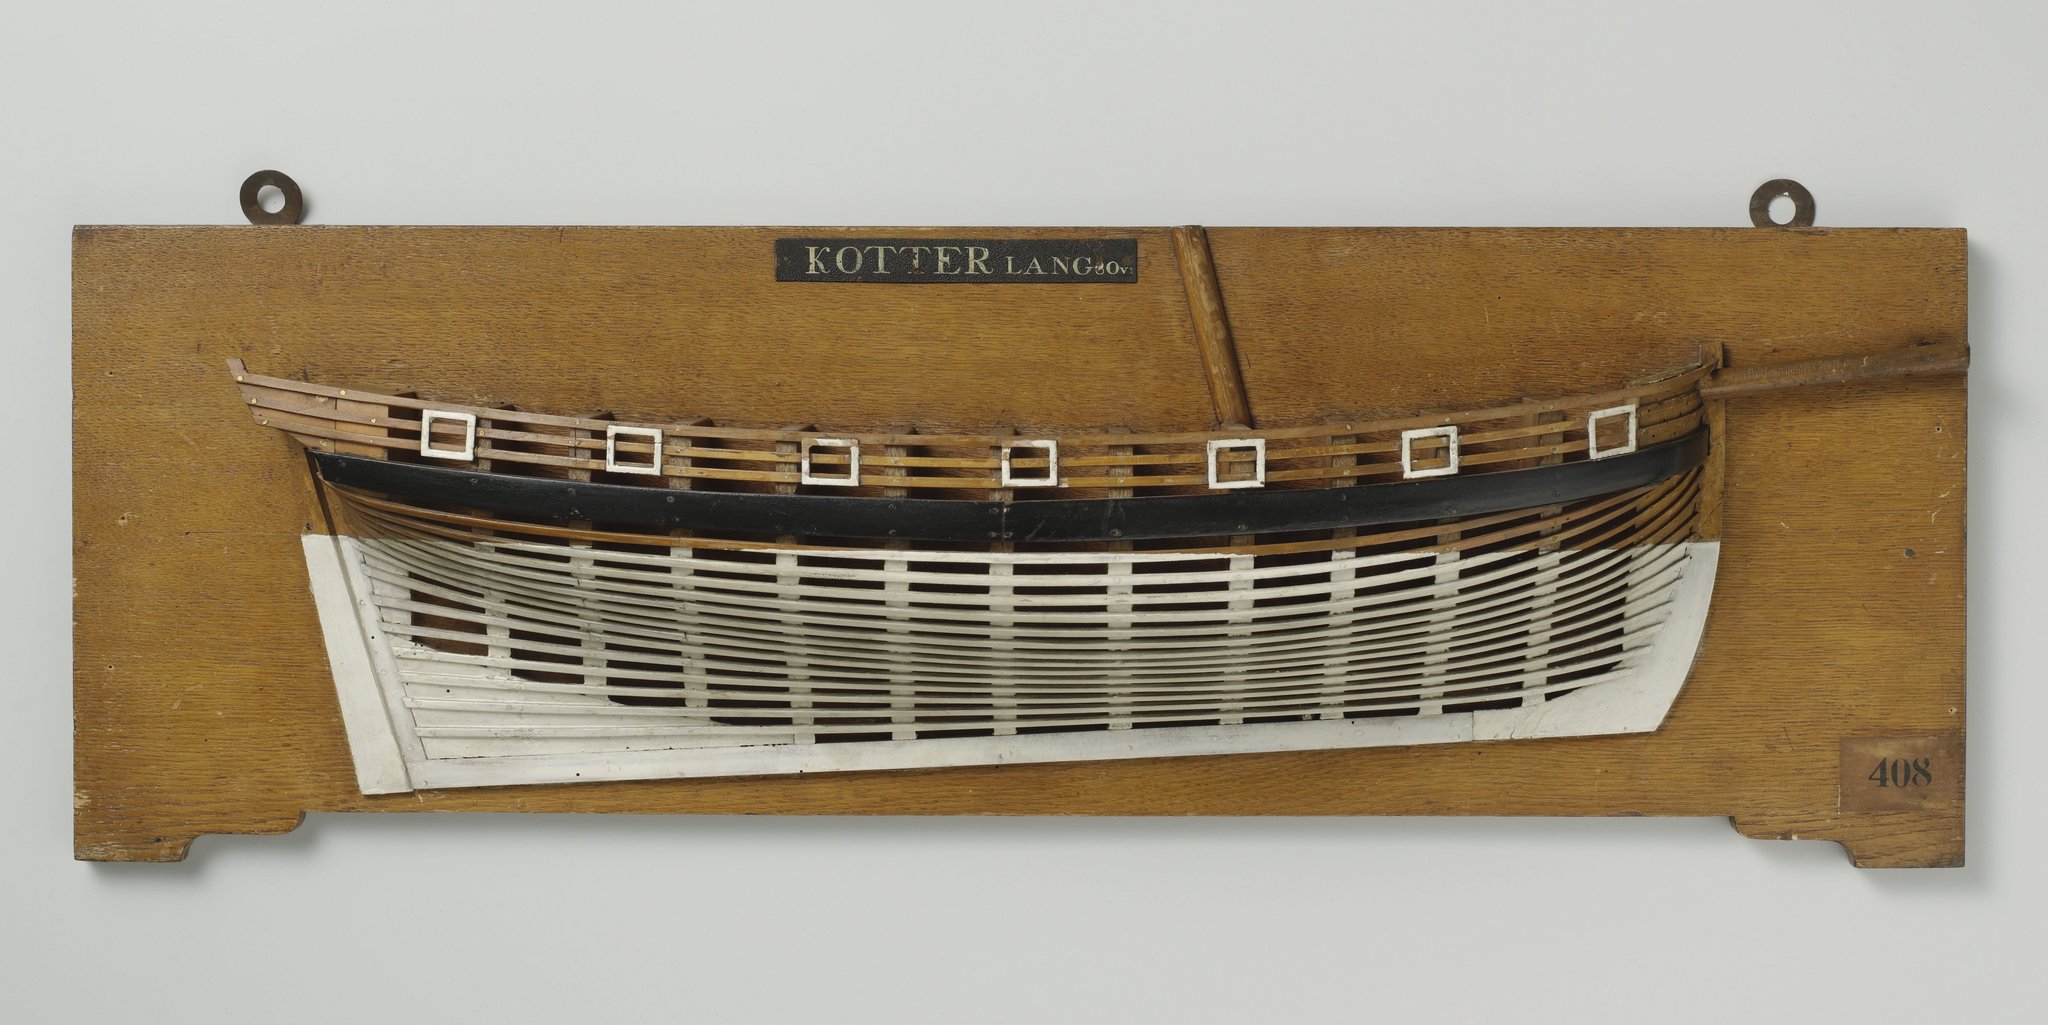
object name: builder's model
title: Half Model of a 14-Gun Cutter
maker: Anonymous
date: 1780-1820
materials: wood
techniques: polychromy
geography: netherlands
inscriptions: inscription, top centre, on a rectangular black label: ‘KOTTER LANG 80 vt’, inscription, on the back: ‘KOTTER L80V’, label, bottom right: ‘408’ former inventory label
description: Gepolychromeerd mallenmodel (stuurboord) van een eenmaster. Zeven geschutpoorten op één dek. Gewrongen spiegel, hol wulf, geen details van het hek; recht roer met vierkante roerkoning. De zeeg loopt naar achter en naar voren op, één barkhout. Gepiekt rondspant, scherp onderwaterschip, zeer veel stuurlast. Sterk achterover hellende mast. Schaal 1:40 (afgeleid).